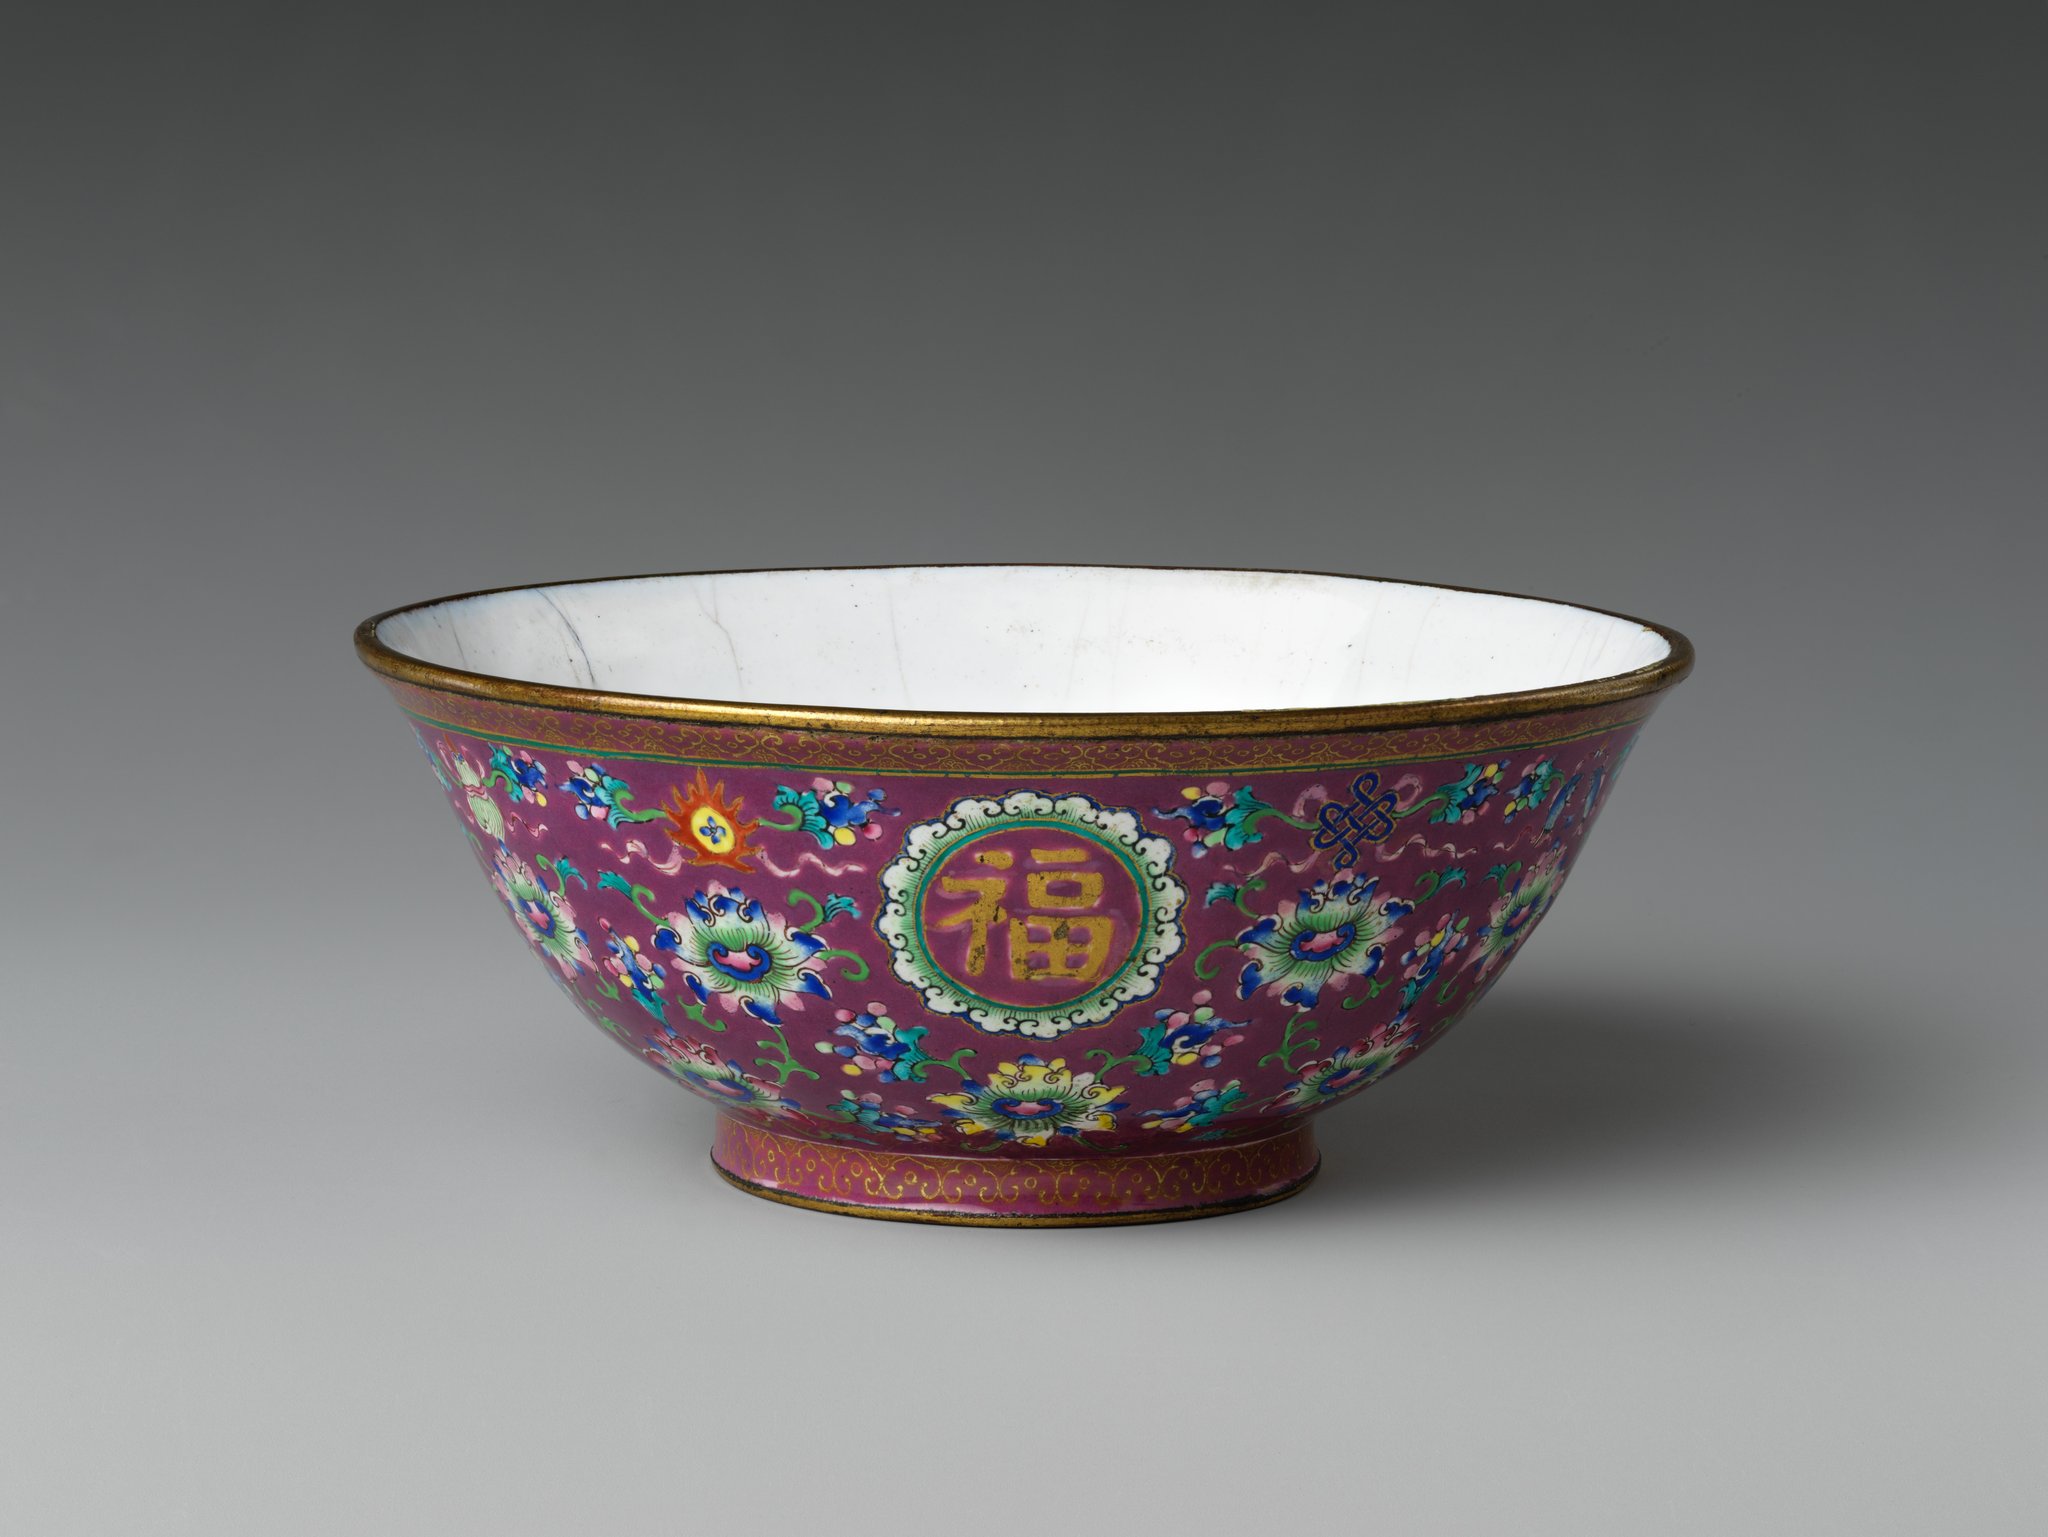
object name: bowl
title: Bowl with auspicious emblems (one of a pair)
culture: chinese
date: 1751-1800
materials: copper alloy, enamel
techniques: painting